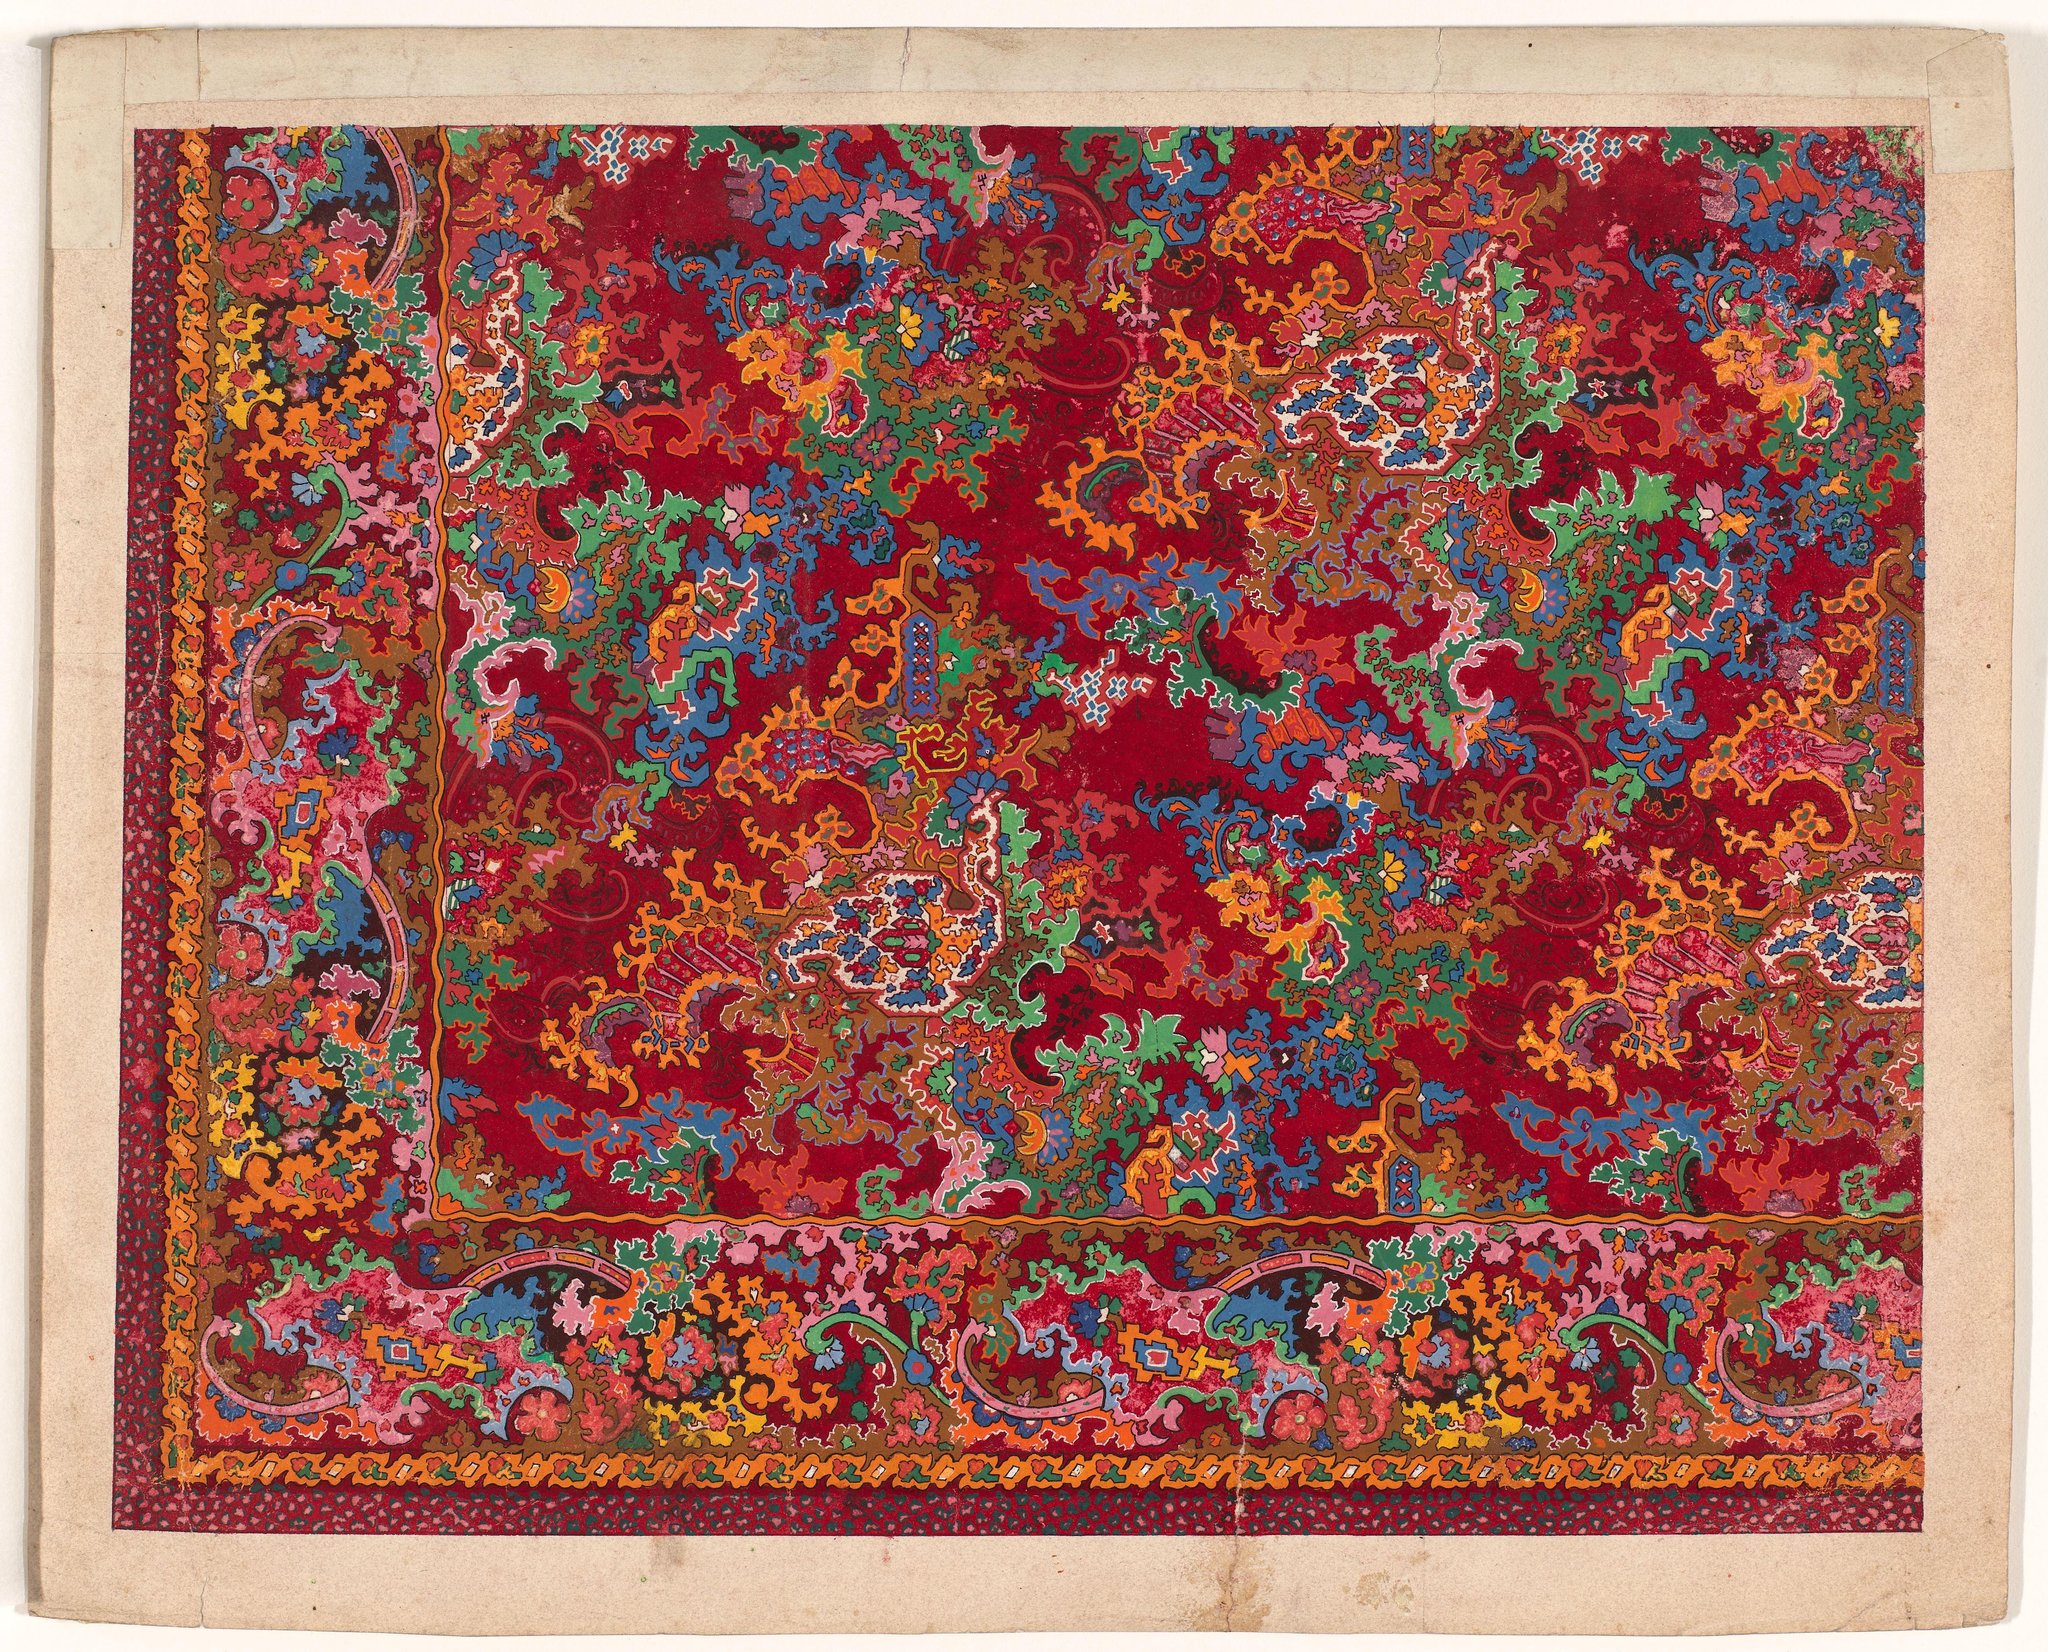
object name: design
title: Ontwerp voor een tapijt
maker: Anonymous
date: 1854-1864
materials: gouache, paper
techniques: brush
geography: deventer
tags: ornaments ~ art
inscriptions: stamp: ‘Koninklyke Tapytfabriek Firma P. van Calcar & Co’, number: ‘N 365’, retailer's mark: ‘JHS.’, inscription: ‘Kan alleen in 1e qualiteit, extra kleuren, gemaakt worden. Prijs f per vierkante/ [...]’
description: De presentatietekeningen BK-1971-77-1 t/m 86 zijn kopieën van de originele ontwerptekeningen. Ze werden gemaakt voor vertegenwoordigers van bijvoorbeeld magazijnen, die ze aan hun klanten konden tonen. De meeste tekeningen tonen een kwart van het dessin inclusief rand, middenpartij (de zogenaamde grond of fond) en centraal medaillon. Door het gebruik van spiegels kan de illusie van het gehele tapijt worden opgeroepen. Een deel van de tekeningen heeft een alfabetische opeenvolgende letter als kenmerk, de andere groep een cijfer.Waarschijnlijk is de reeks dessins met een letter eerder samengesteld dan de genummerde tekeningen.